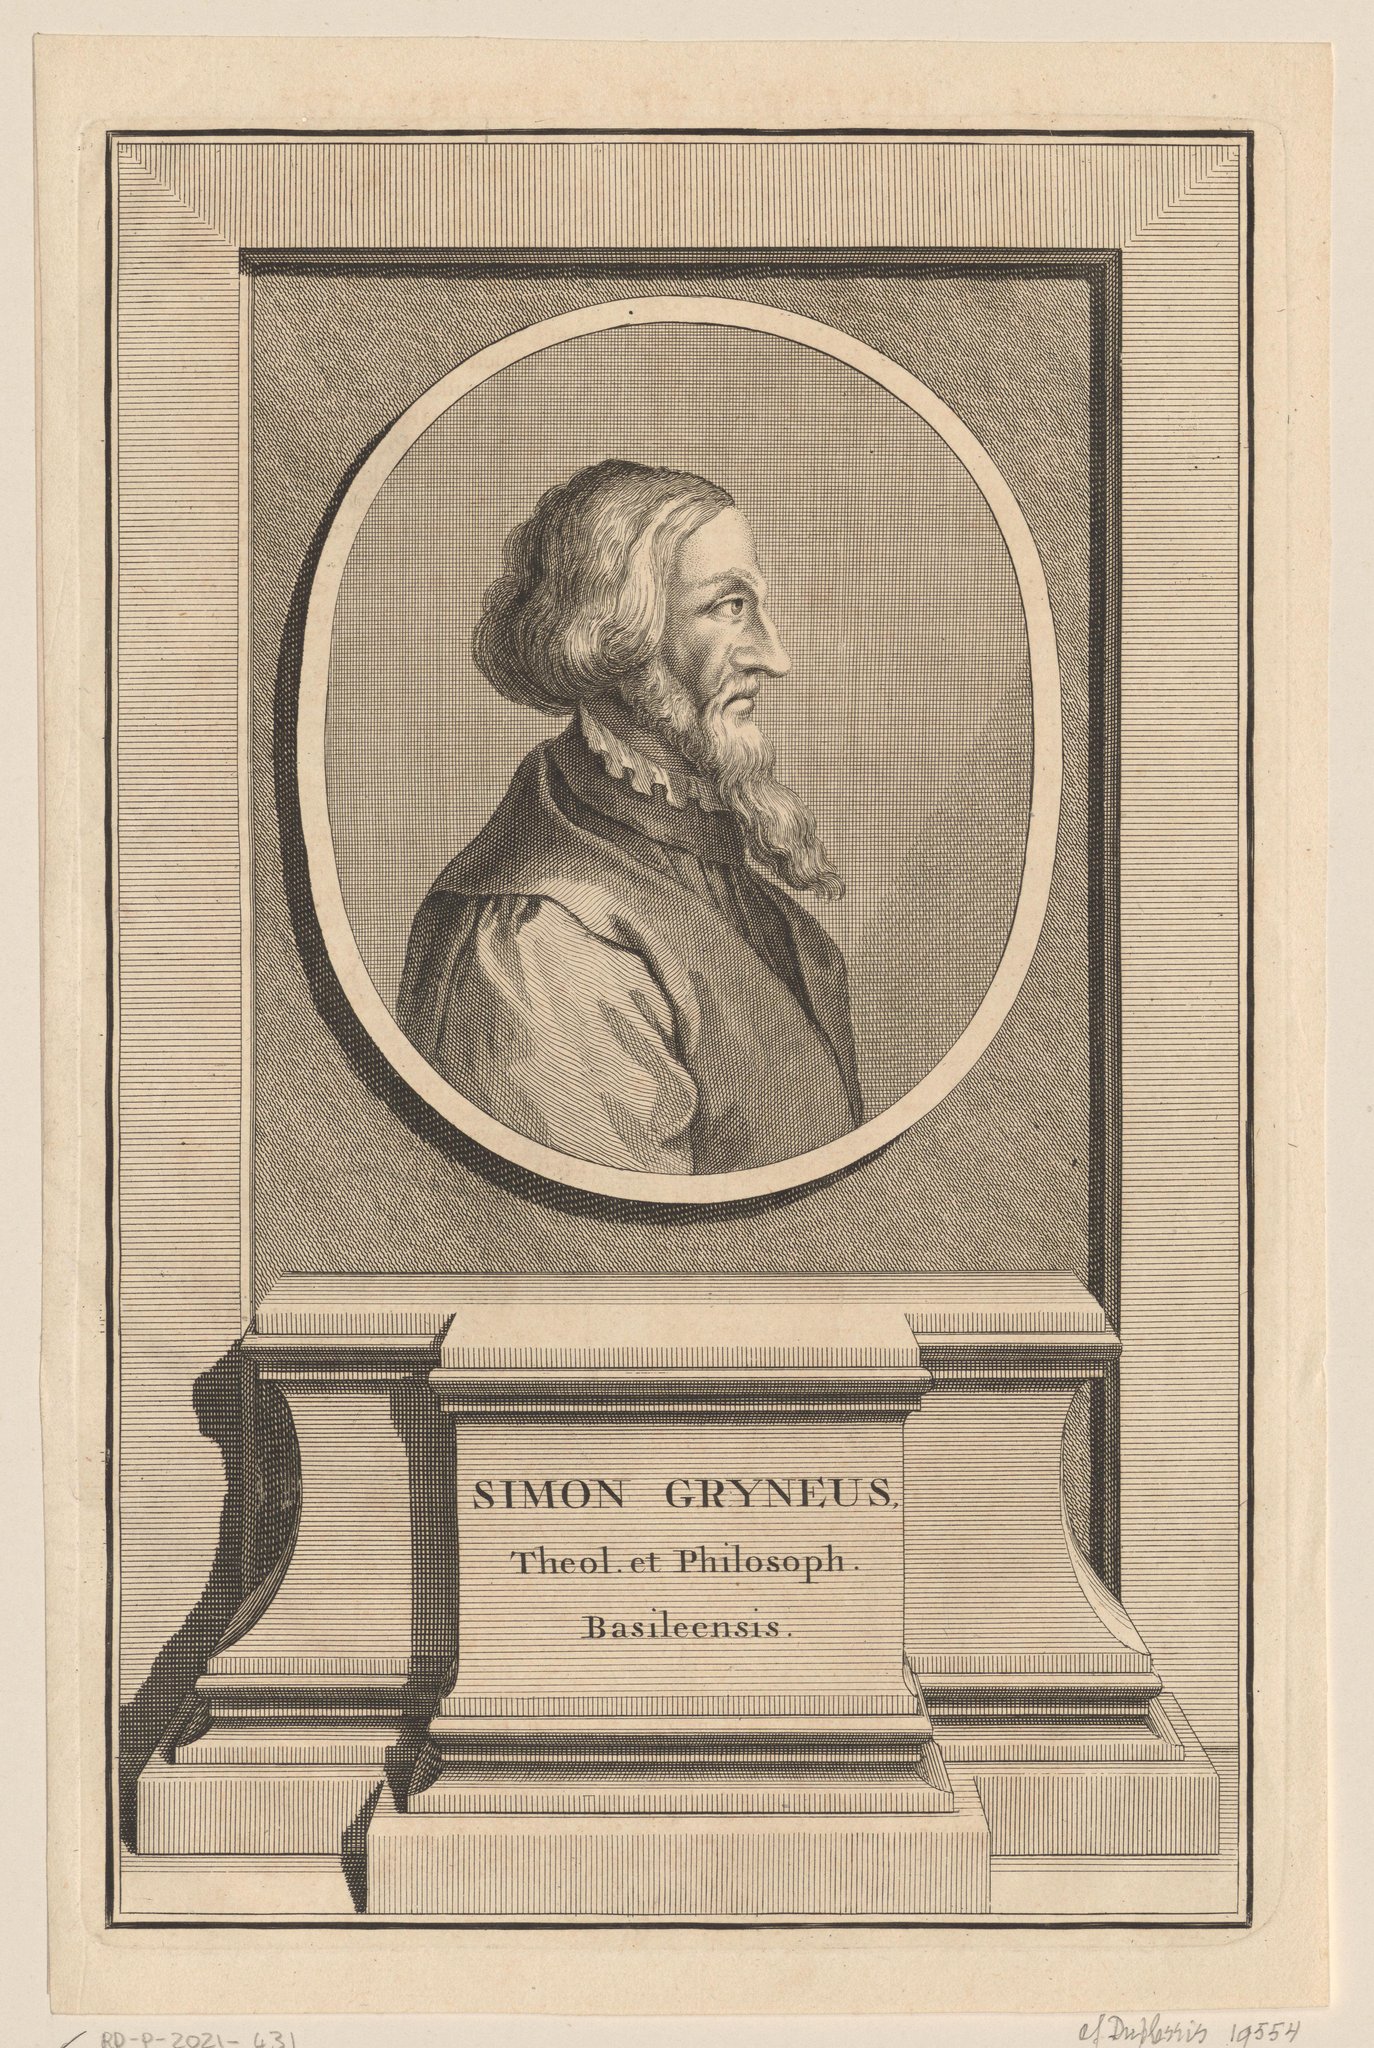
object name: print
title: Portret van Simon Grynaeus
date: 1650-1750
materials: paper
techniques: engraving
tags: theologian, historical persons